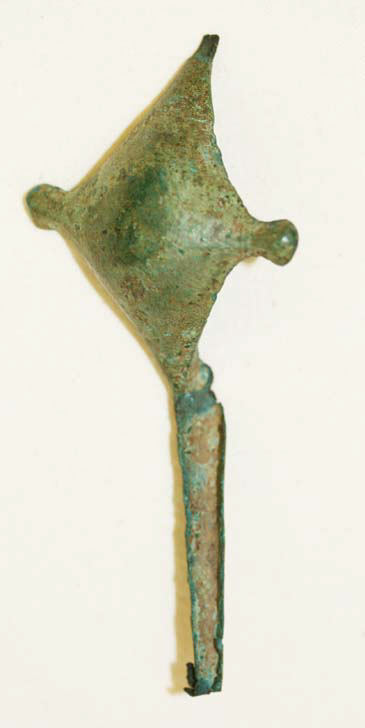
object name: pin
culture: european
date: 400-301 BCE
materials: bronze